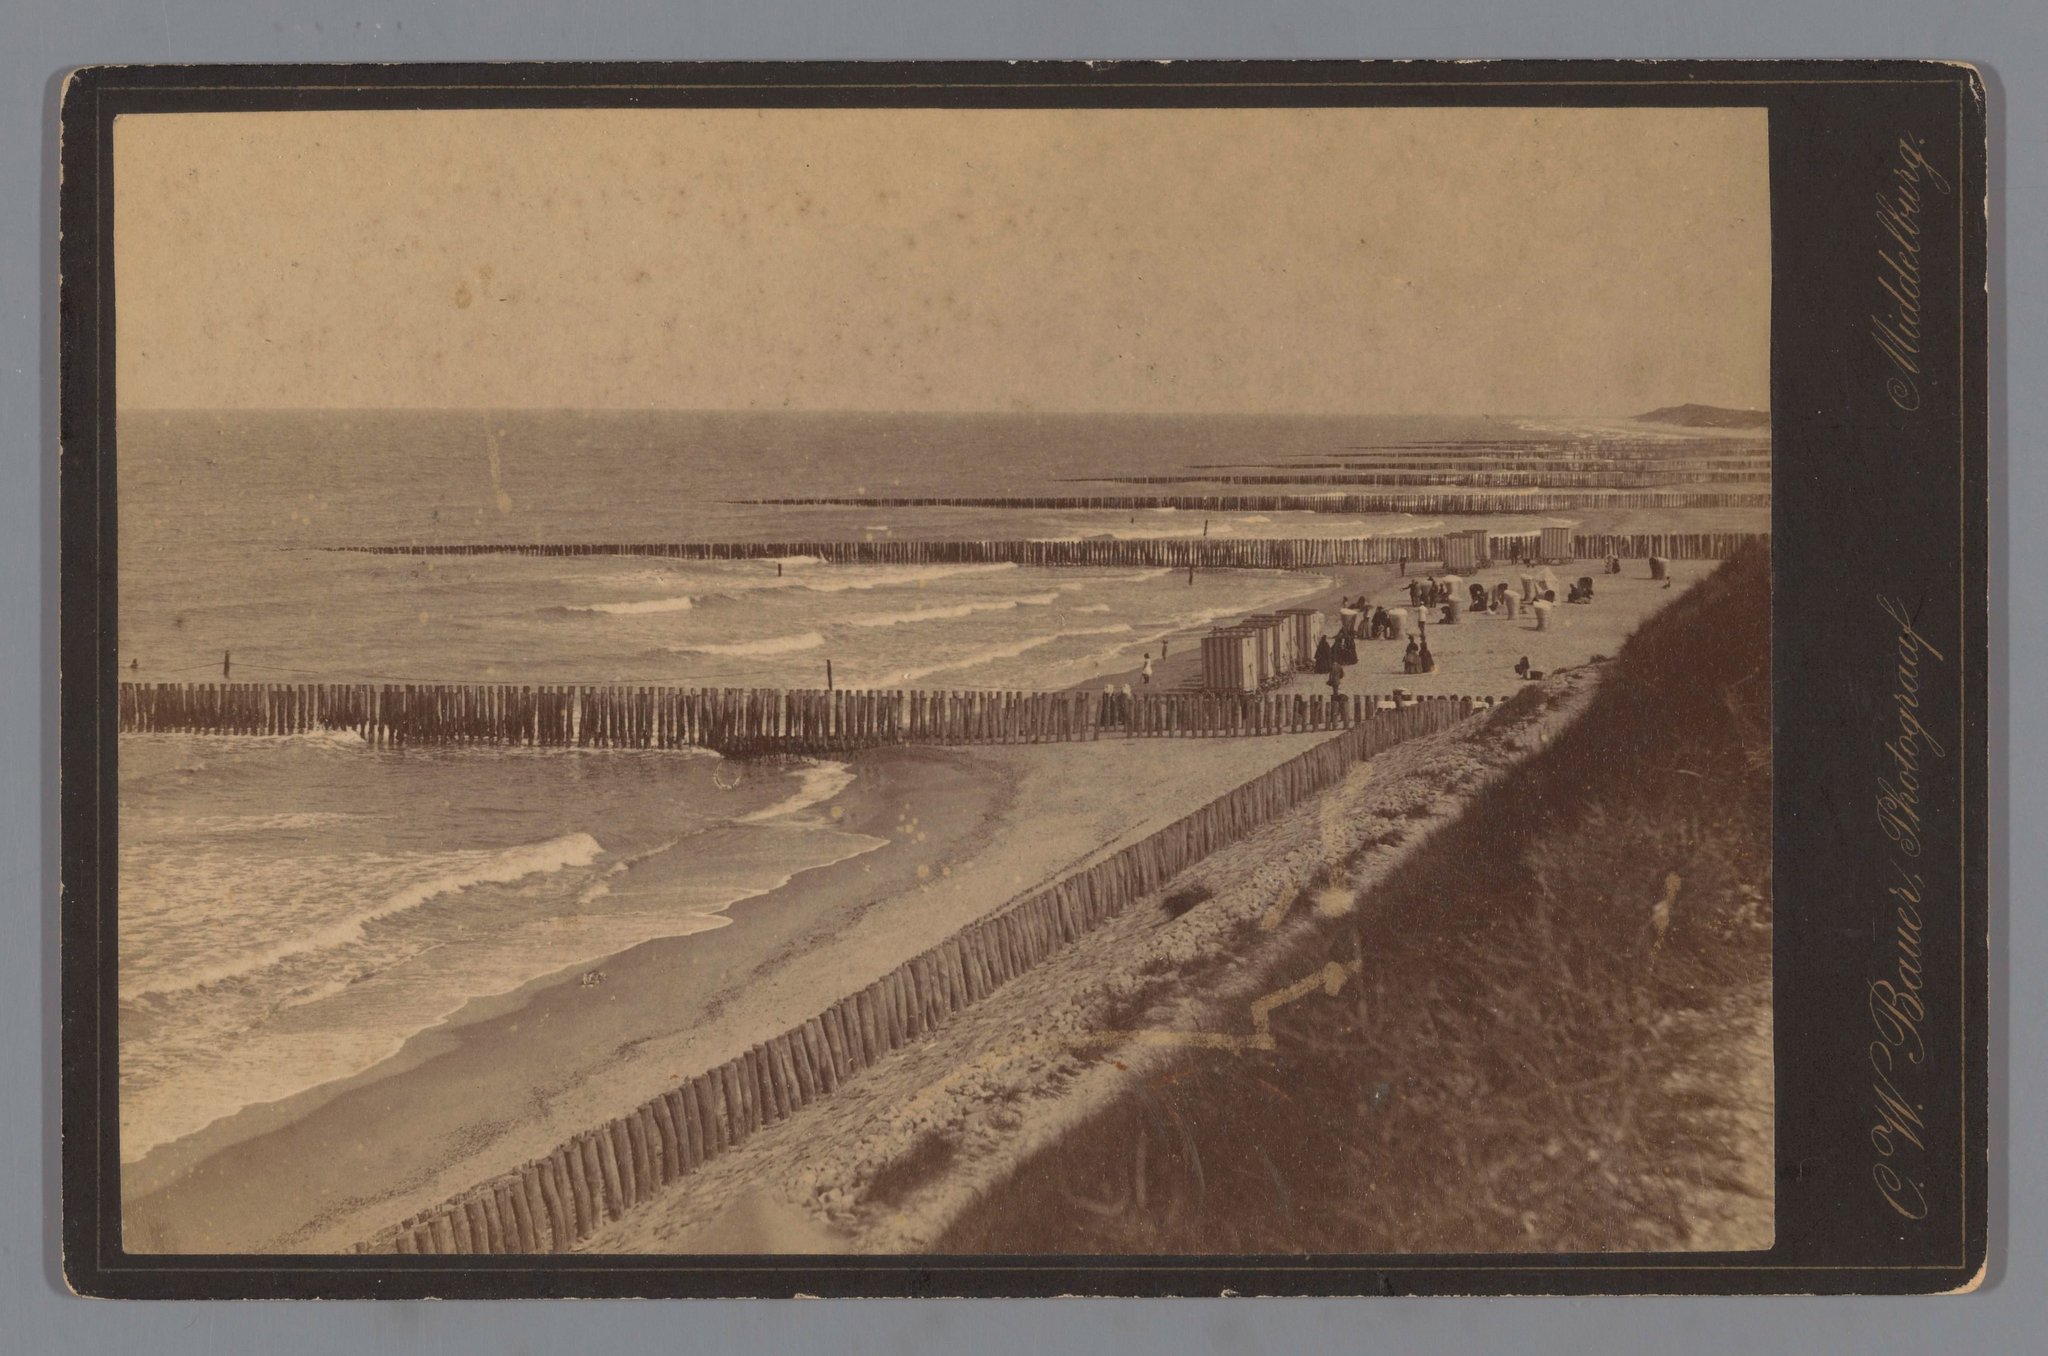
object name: cabinet photograph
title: Gezicht op strand van Zeeland met zeeweringen en kleedhokjes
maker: carl wilhelm bauer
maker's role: fotograaf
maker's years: 1844-1911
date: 1850-1900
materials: cardboard, photographic support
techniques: albumen print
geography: middelburg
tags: beach, zeeland